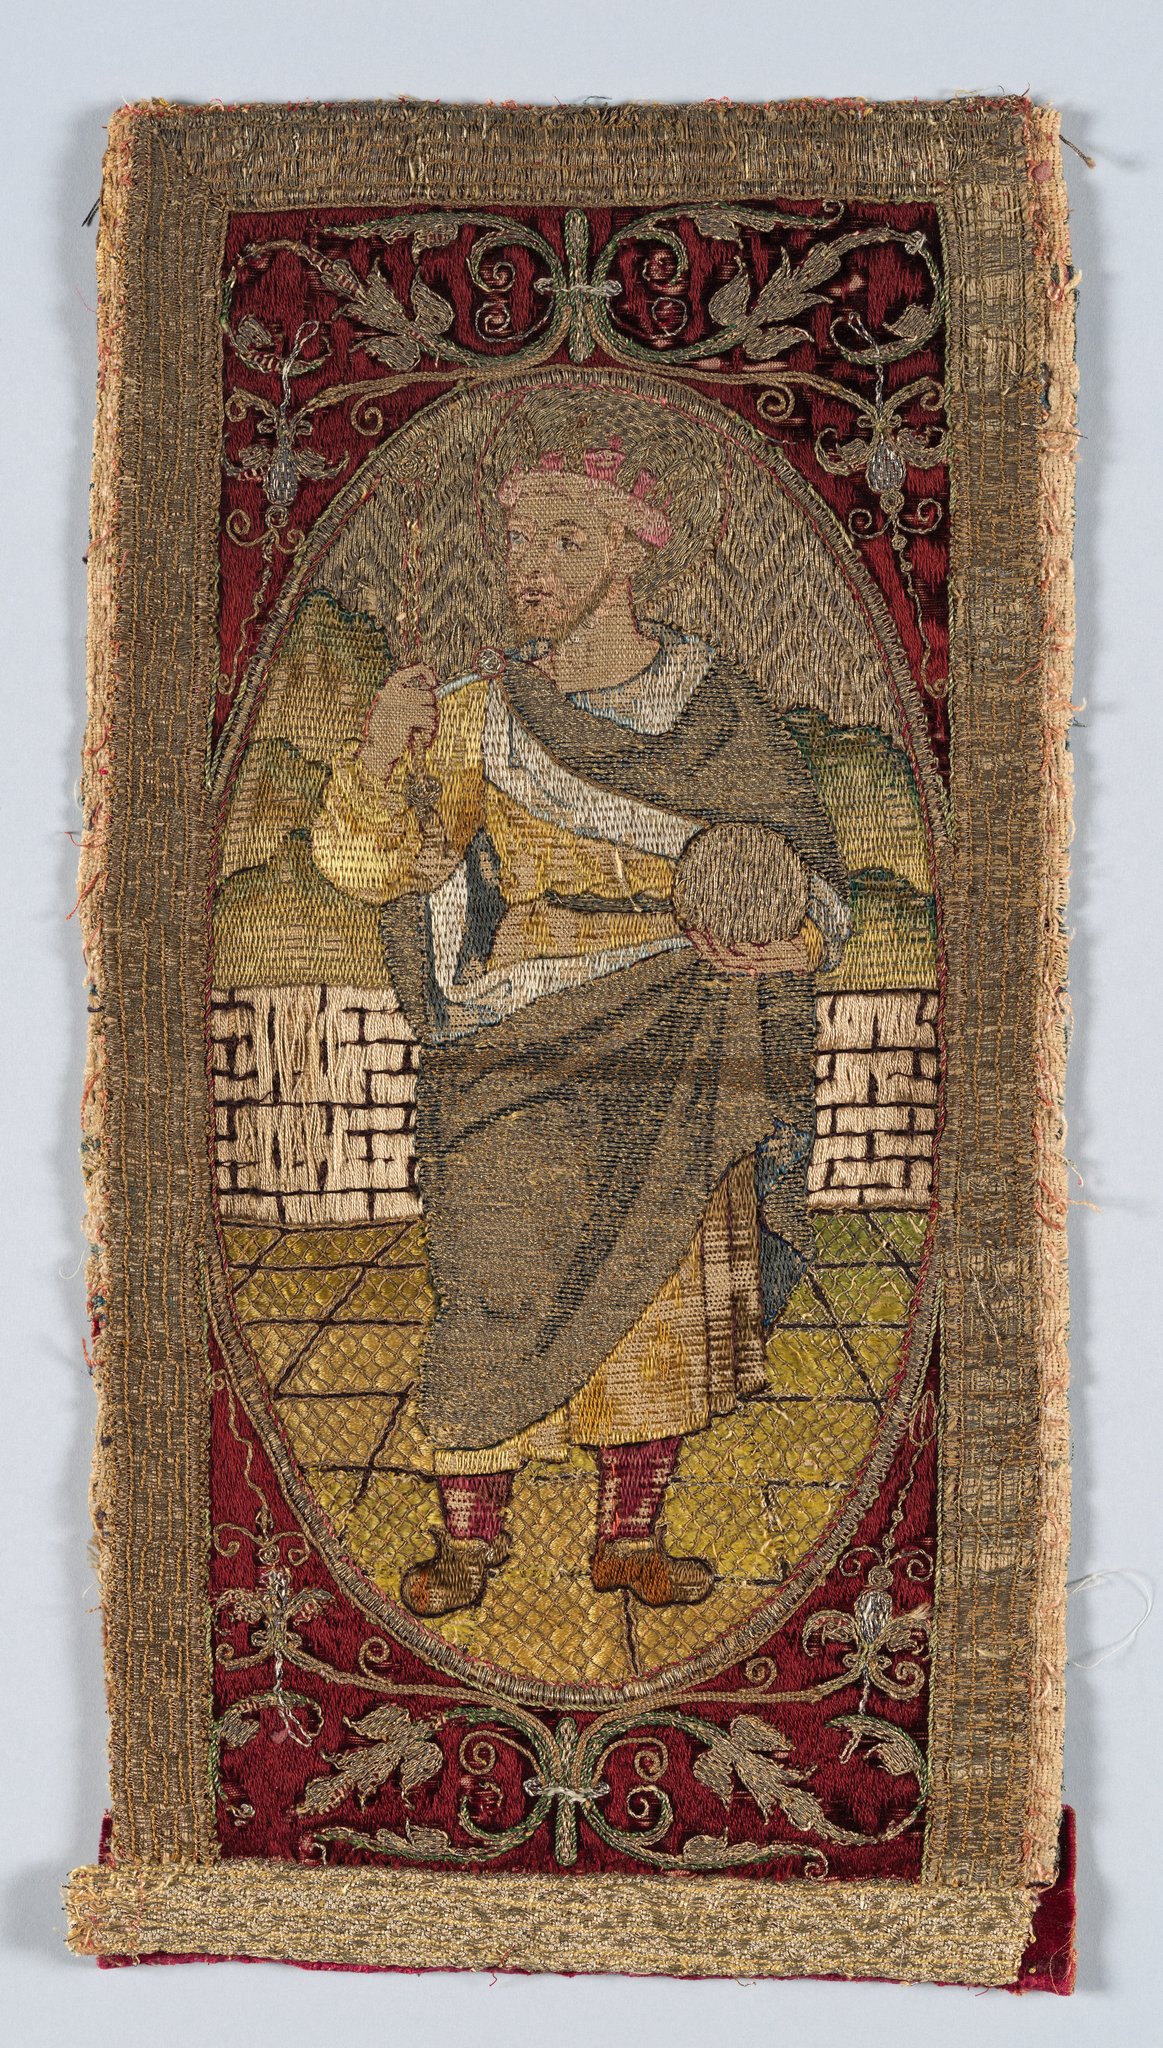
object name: cushion made from orphrey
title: Orphrey section made into cushion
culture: italian or spanish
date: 1551-1600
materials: linen, metal, silk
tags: men